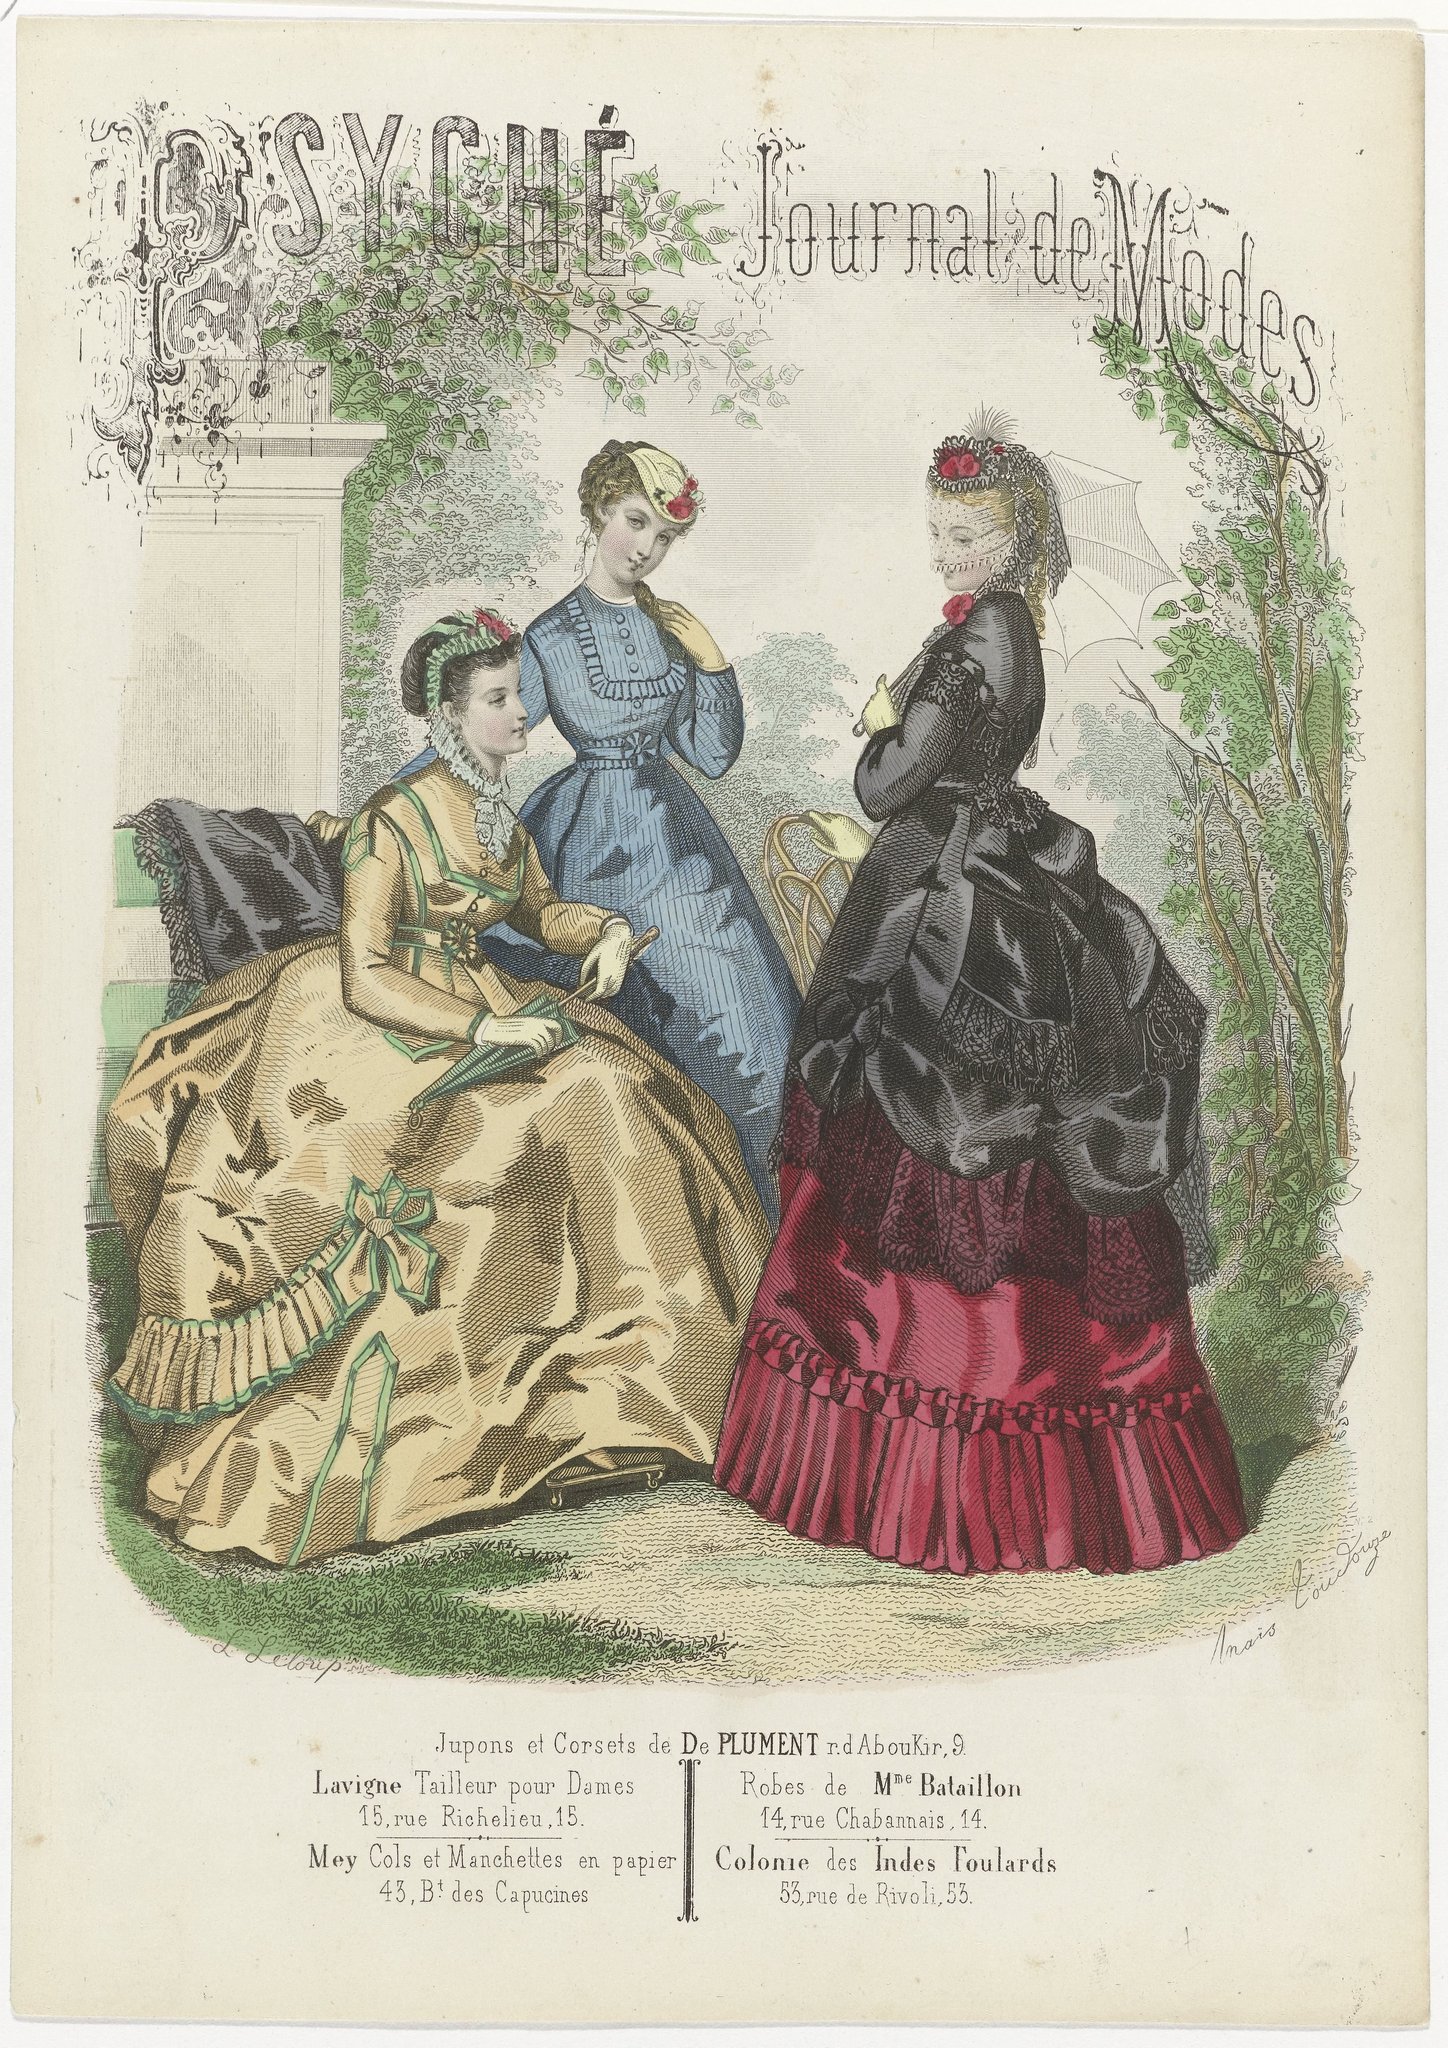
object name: fashion print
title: Psyché Journal de Modes, ca. 1870 : Jupons et Corsets (...)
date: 1870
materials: paper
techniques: engraving, hand coloring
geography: paris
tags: veil (+ women's clothes), head-gear (+ women's clothes), fashion plates, skirt (+ women's clothes), gloves, mittens, etc. (+ women's clothes), dress, gown (+ women's clothes), parasol, sunshade (+ women's clothes)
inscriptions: caption: ‘Jupons et corsets de De Plument r.d AbouKir, 9. / Lavigne Tailleur pour dames 15, rue Richelieu, 15. / Mey Cols et Manchettes en papier 43, Bt des Capucines / Robes de Mme Bataillon 14, rue Chabannais, 14. / Colonie des Indes Foulards 53, rue de Ricoli, 53.’, title: ‘Psyché Journal de Modes’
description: Drie vrouwen zijn buiten, gekleed in japonnen van Bataillon en de kragen en manchetten zijn van Mey. De stoffen zijn afkomstig van Colonie des Indes. Prent uit het modetijdschrift Psyché (1834-1878).